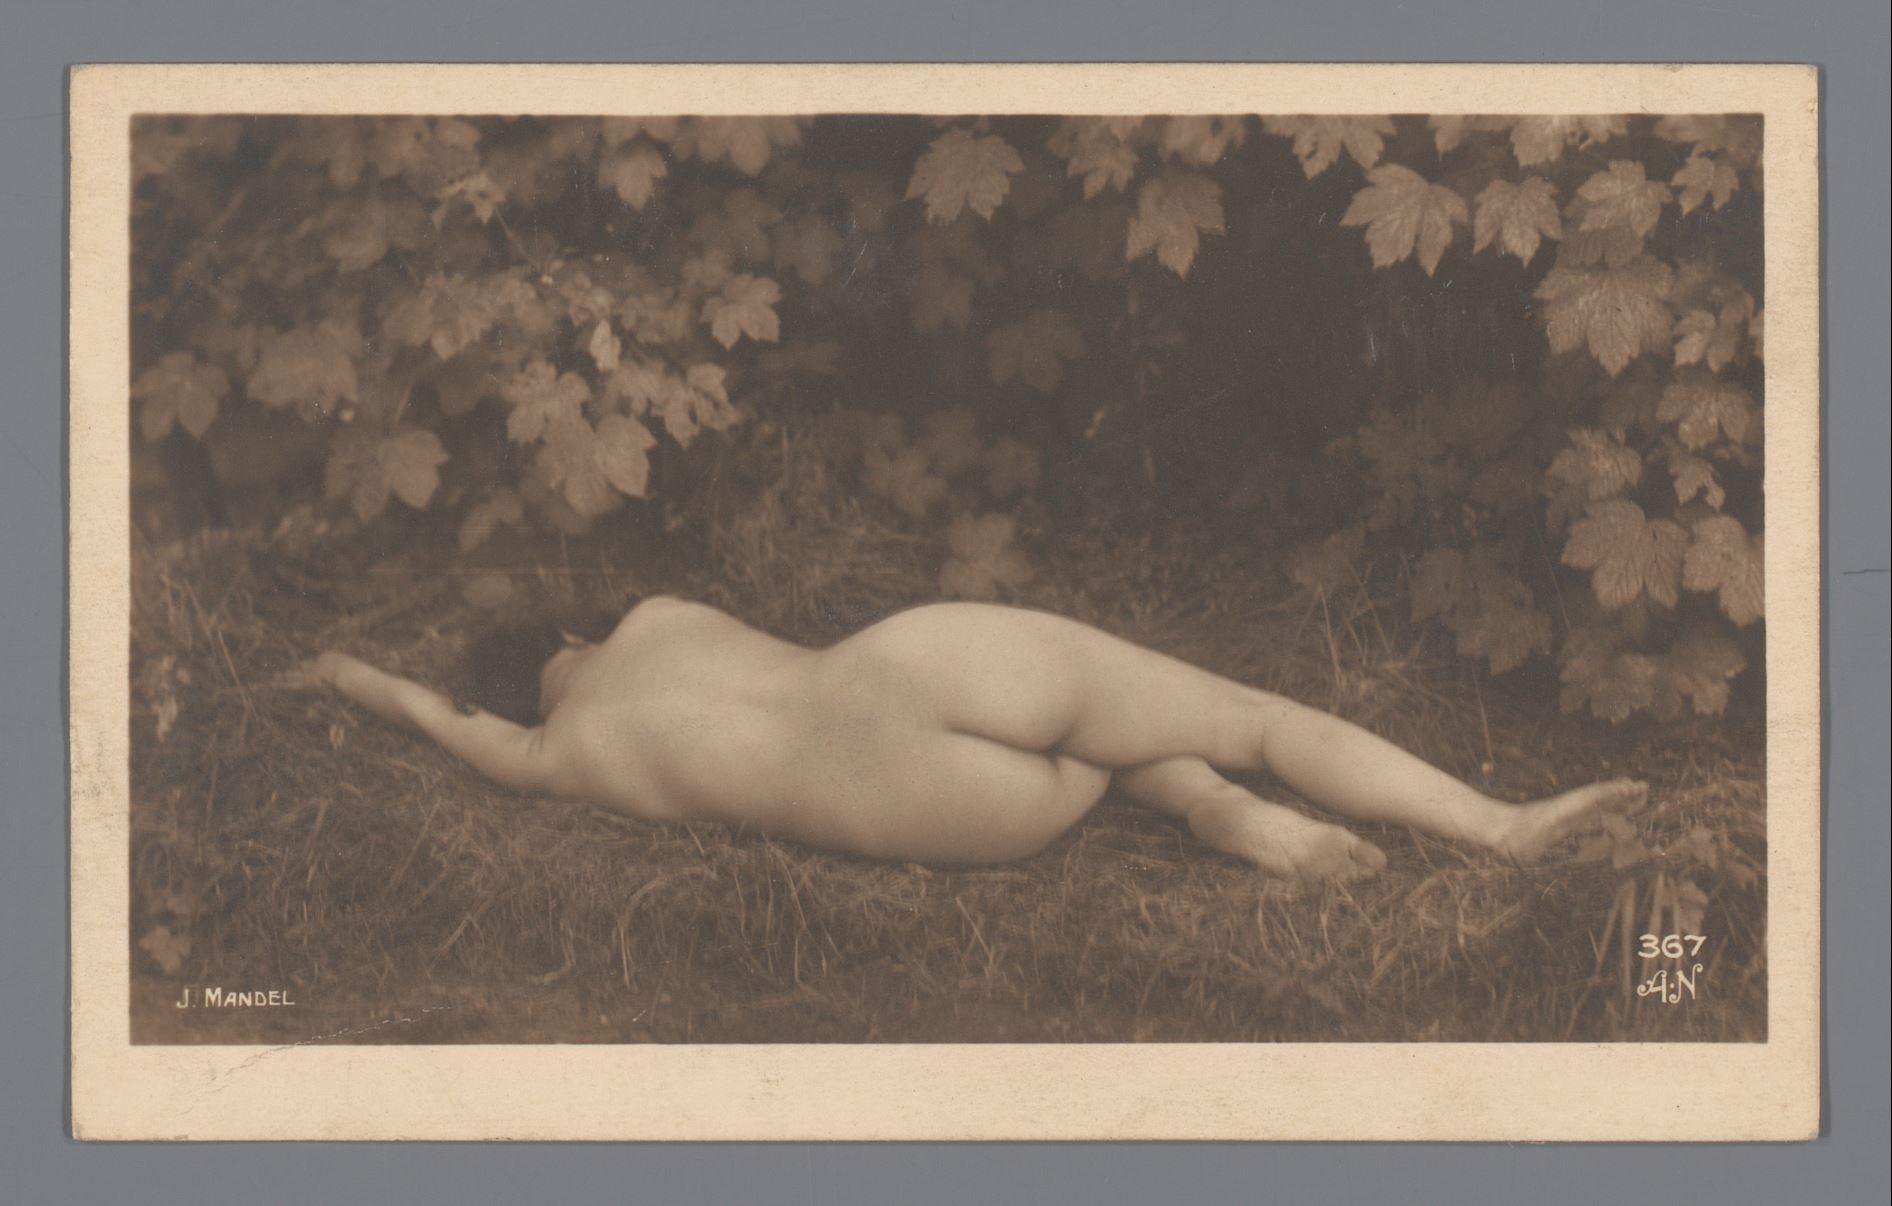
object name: photograph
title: Vrouwelijk naakt op de rug gezien, liggend in het gras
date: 1900-1930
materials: cardboard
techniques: collodion silver print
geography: paris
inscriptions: inscription: ‘367//A.N’, signature: ‘J. Mandel’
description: Vrouwelijk naakt op de rug gezien, liggend in het gras, met struiken op de achtergrond.